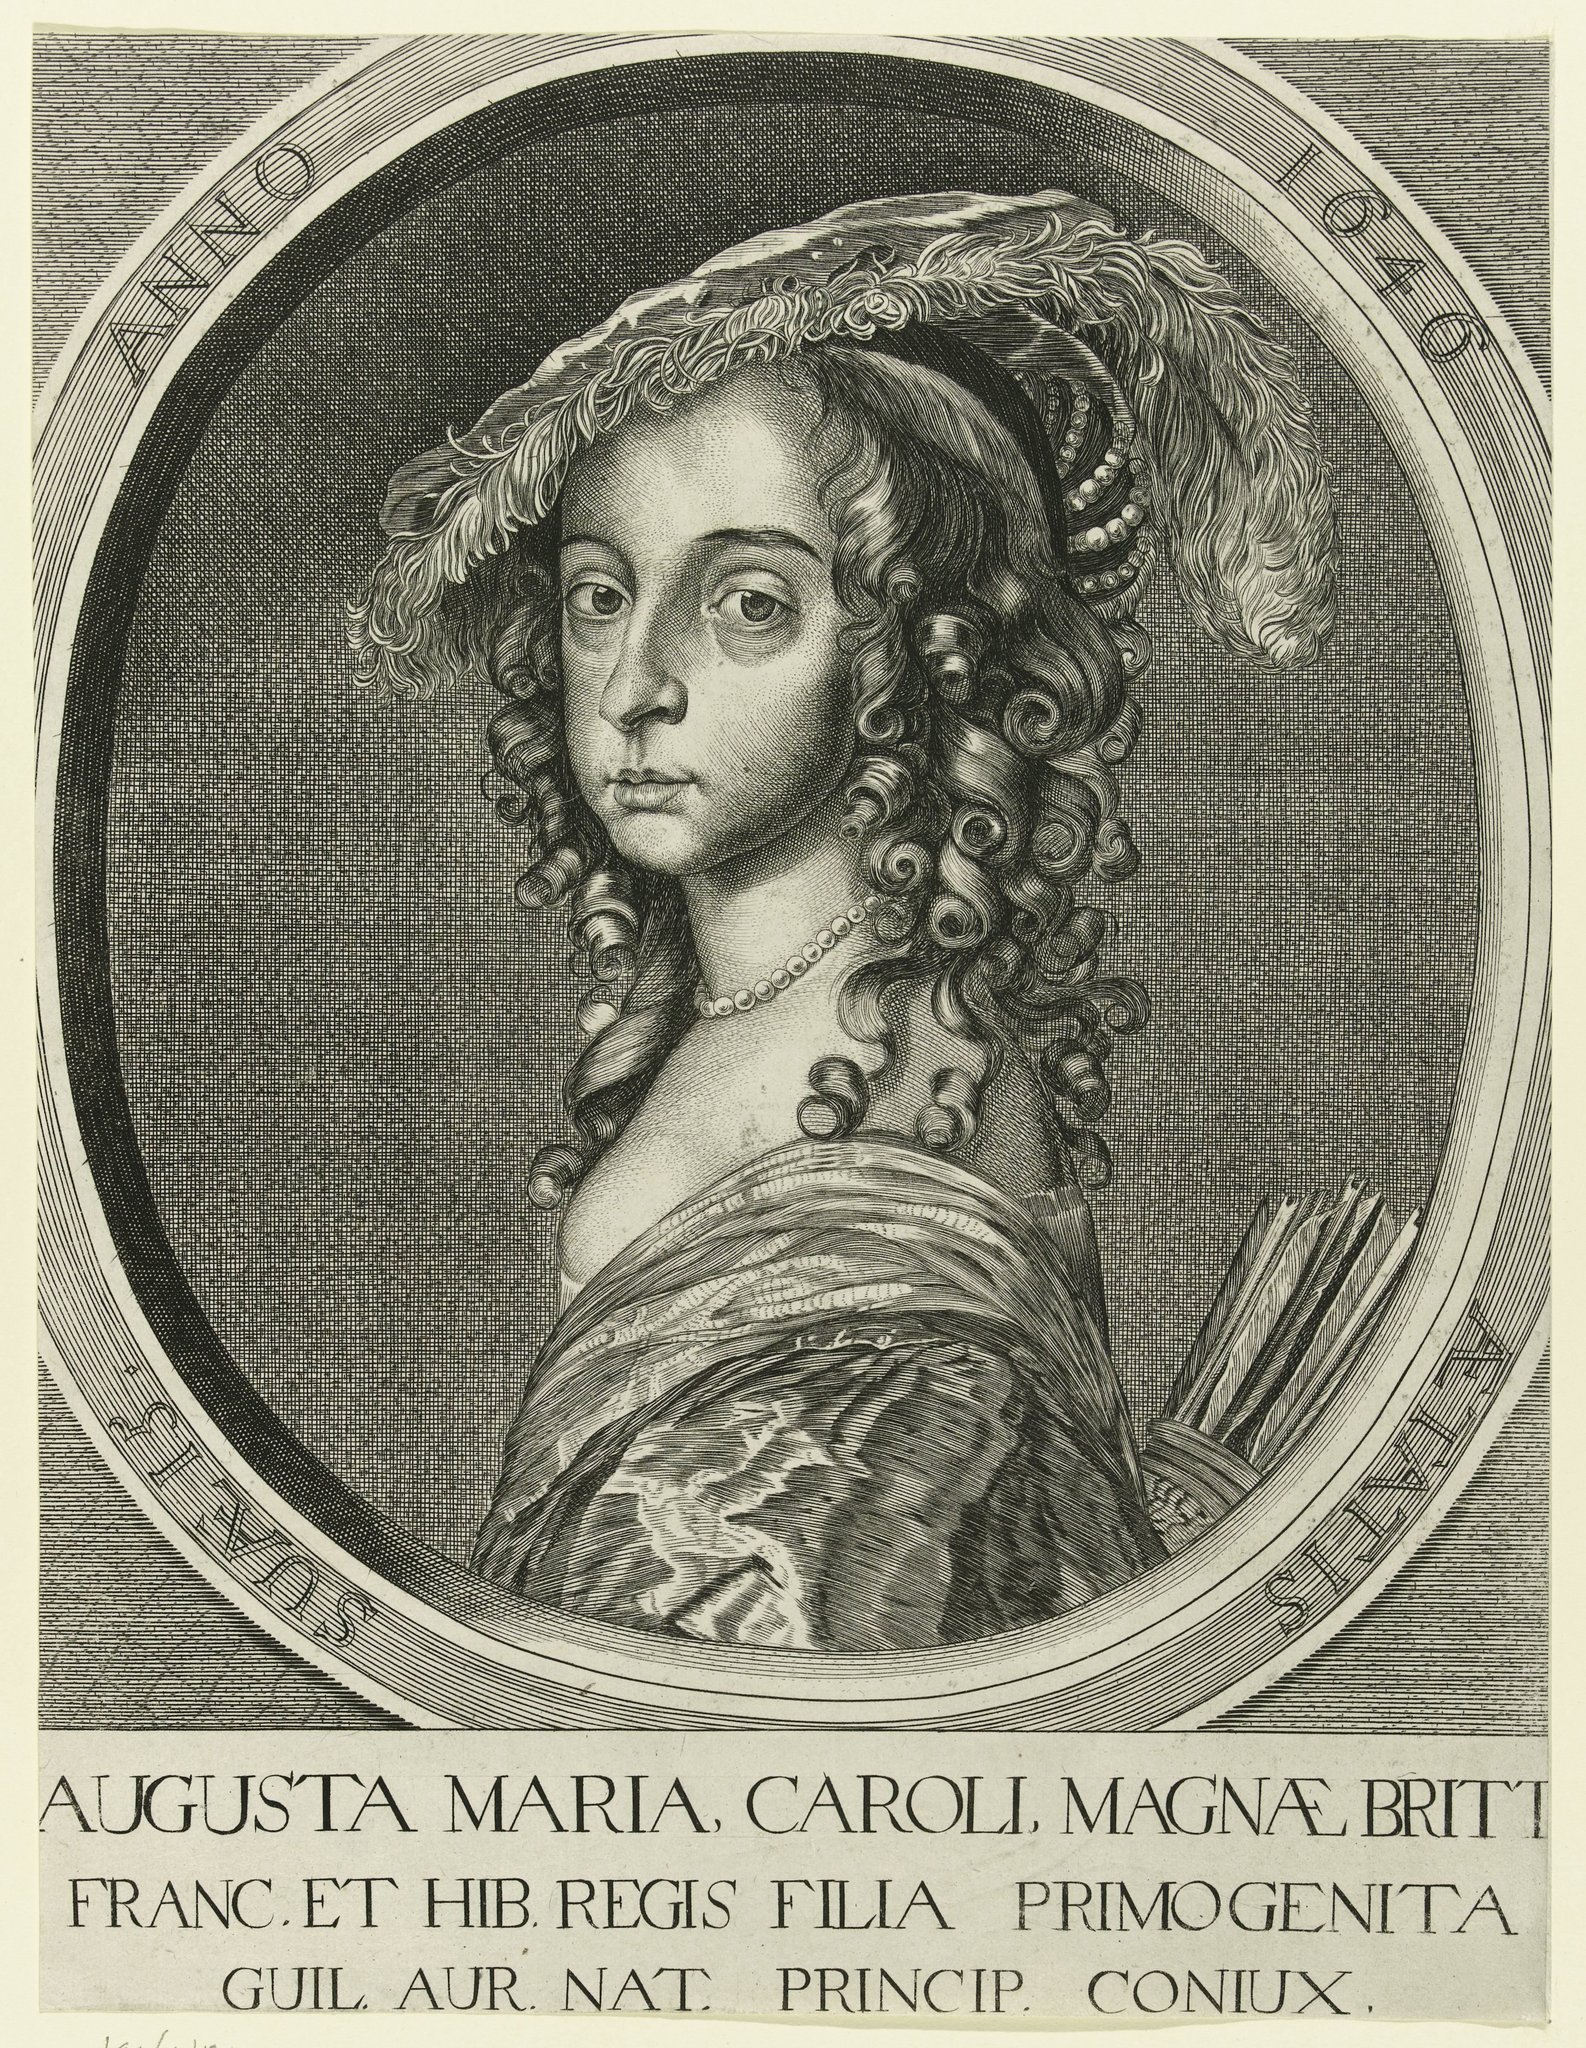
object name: print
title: Portret van Maria Henrietta Stuart, op 15-jarige leeftijd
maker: Anonymous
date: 1650-1749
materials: paper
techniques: engraving, etching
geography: low countries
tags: mary henrietta stuart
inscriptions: collector's mark: Lugt 2228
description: Portret van Maria Henrietta in een ovaal met randschrift. In de ondermarge drie regels Latijnse tekst.